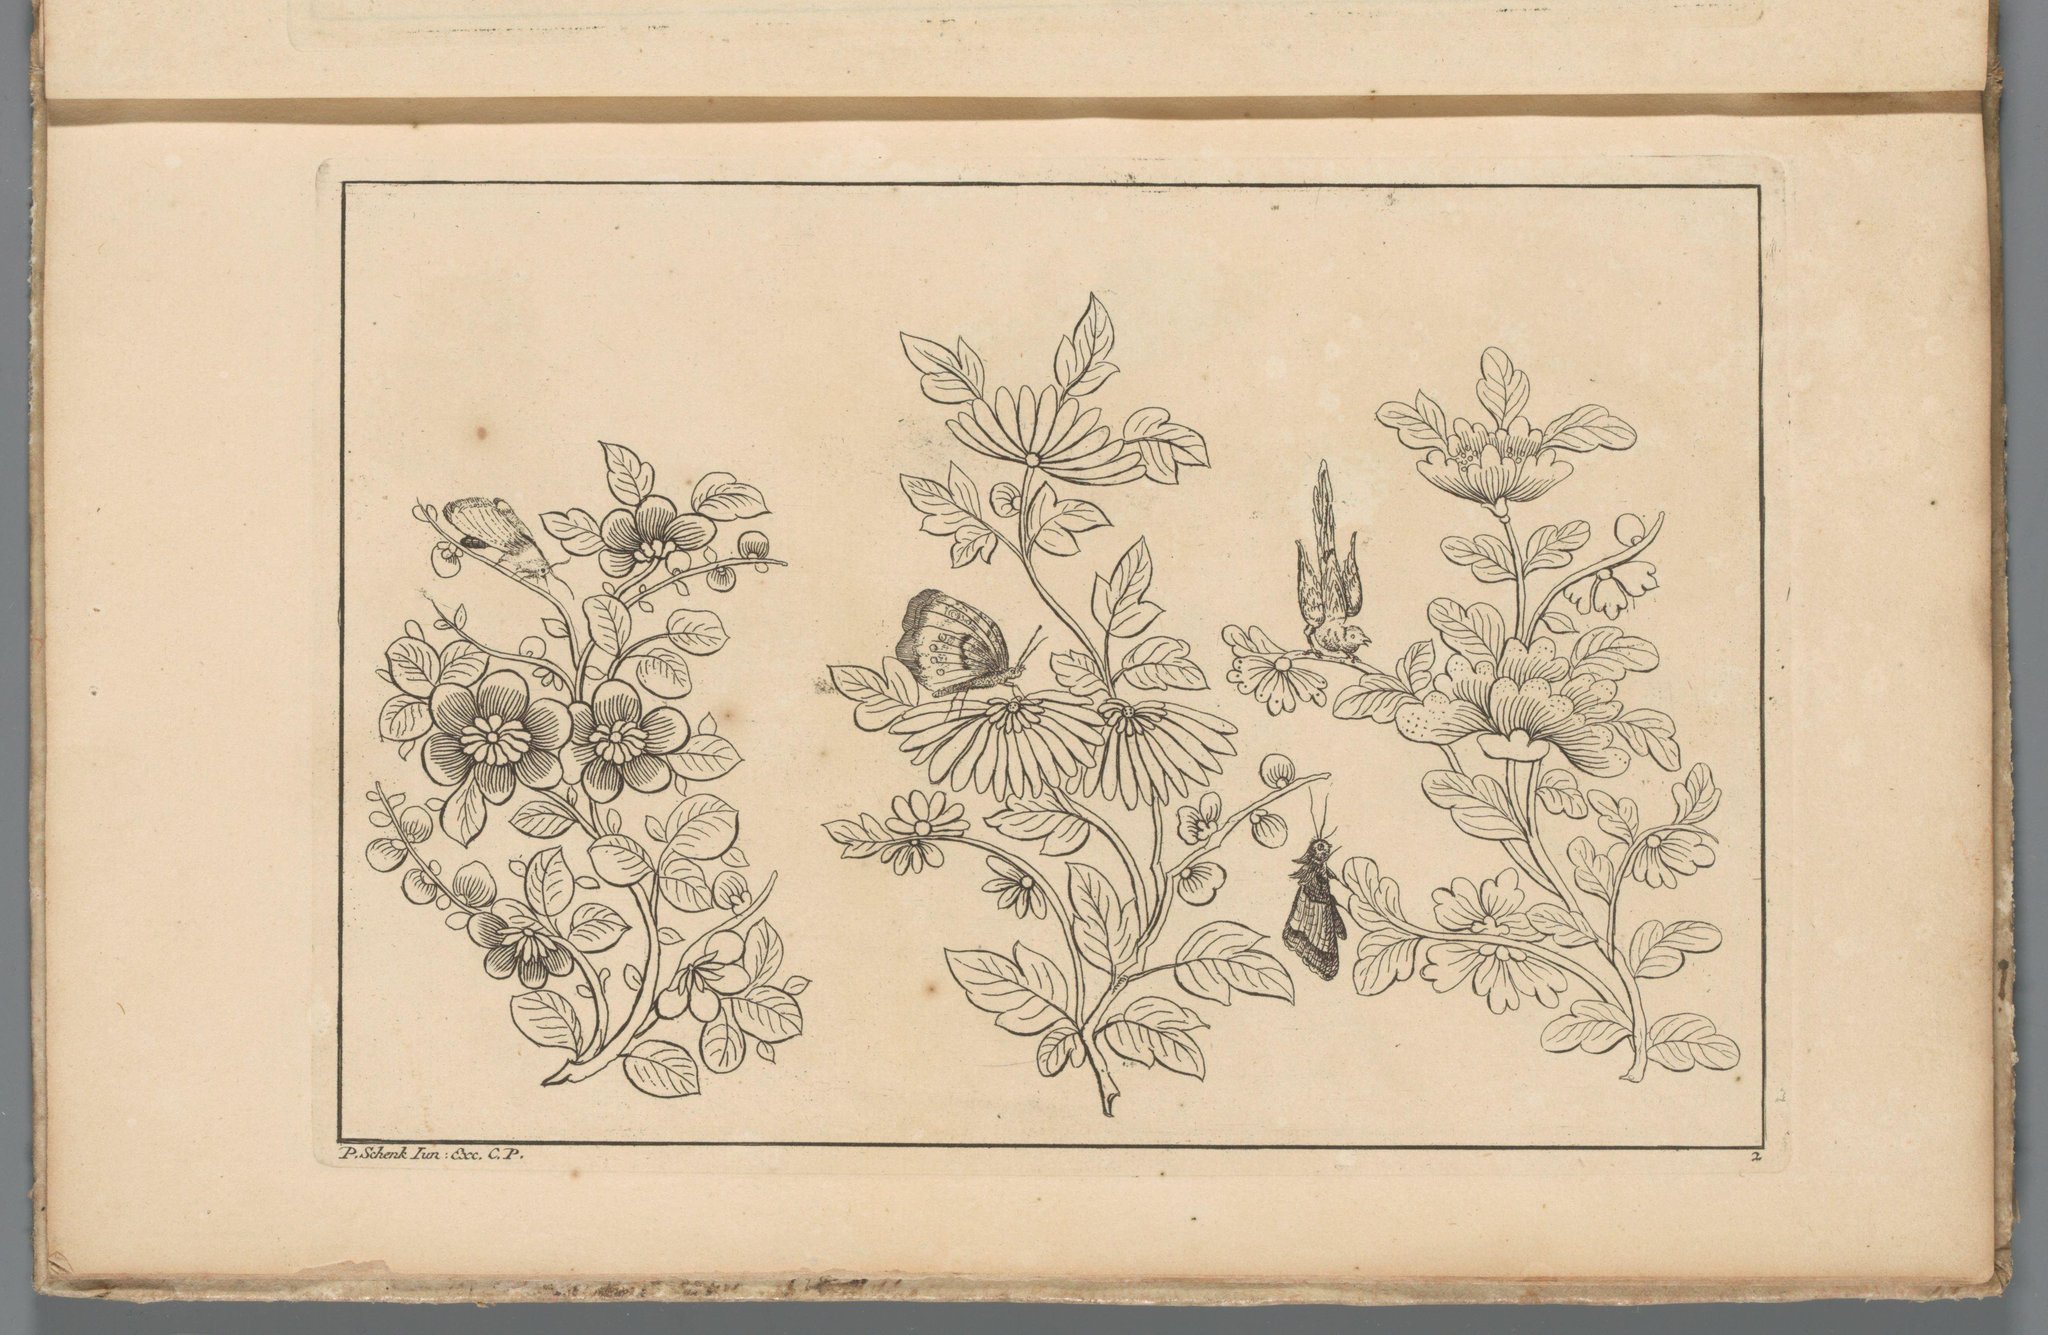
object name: print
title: Chinese bloemen en insecten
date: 1727-1775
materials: paper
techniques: etching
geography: amsterdam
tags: flowers, chinese, insects: butterfly